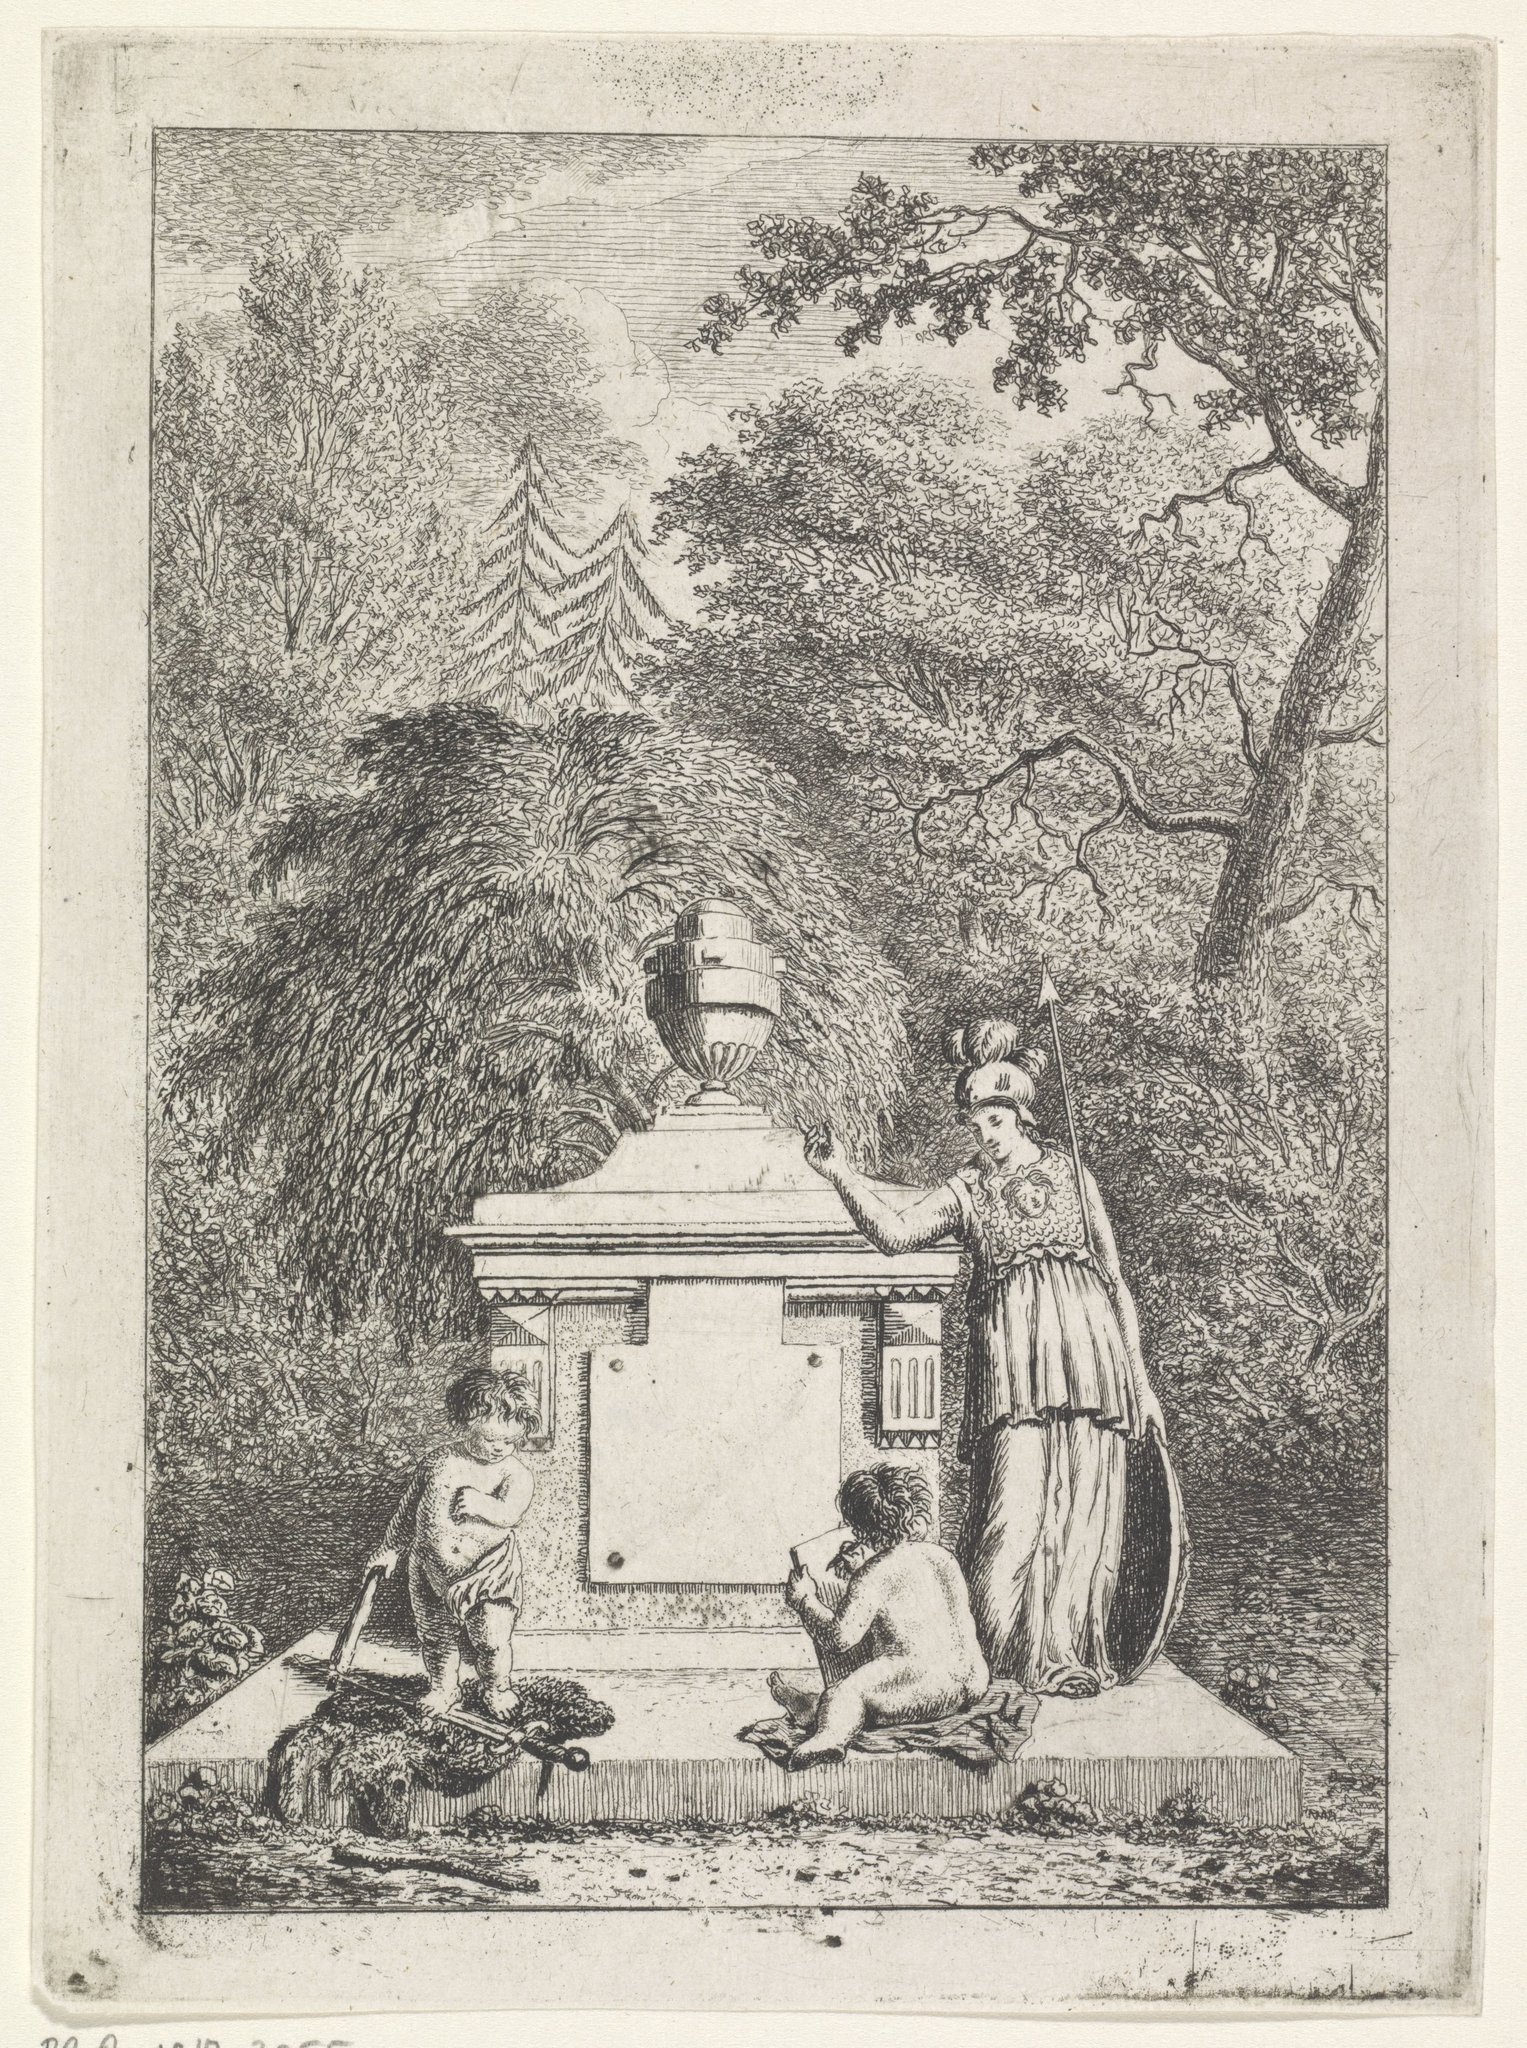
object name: print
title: Allegorisch grafmonument voor de Leidse student S. van Schaak, 1794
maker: johannes christiaan janson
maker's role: draughtsman, painter, print maker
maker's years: 1763-1823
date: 1794-1796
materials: paper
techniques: etching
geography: northern netherlands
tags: grave-building, monumental tomb, leiden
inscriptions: collector's mark: Lugt 2228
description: Allegorisch grafmonument voor de Leidse student in de medicijnen Samuel van Schaak, die op 2 maart in een gevecht met majoor De Graaf van de schutterij gewond raakte en op 11 maart 1794 aan de gevolgen van zijn verwonding overleed. Twee putti en Minerva bij een grafmonument in bosrijke omgeving.